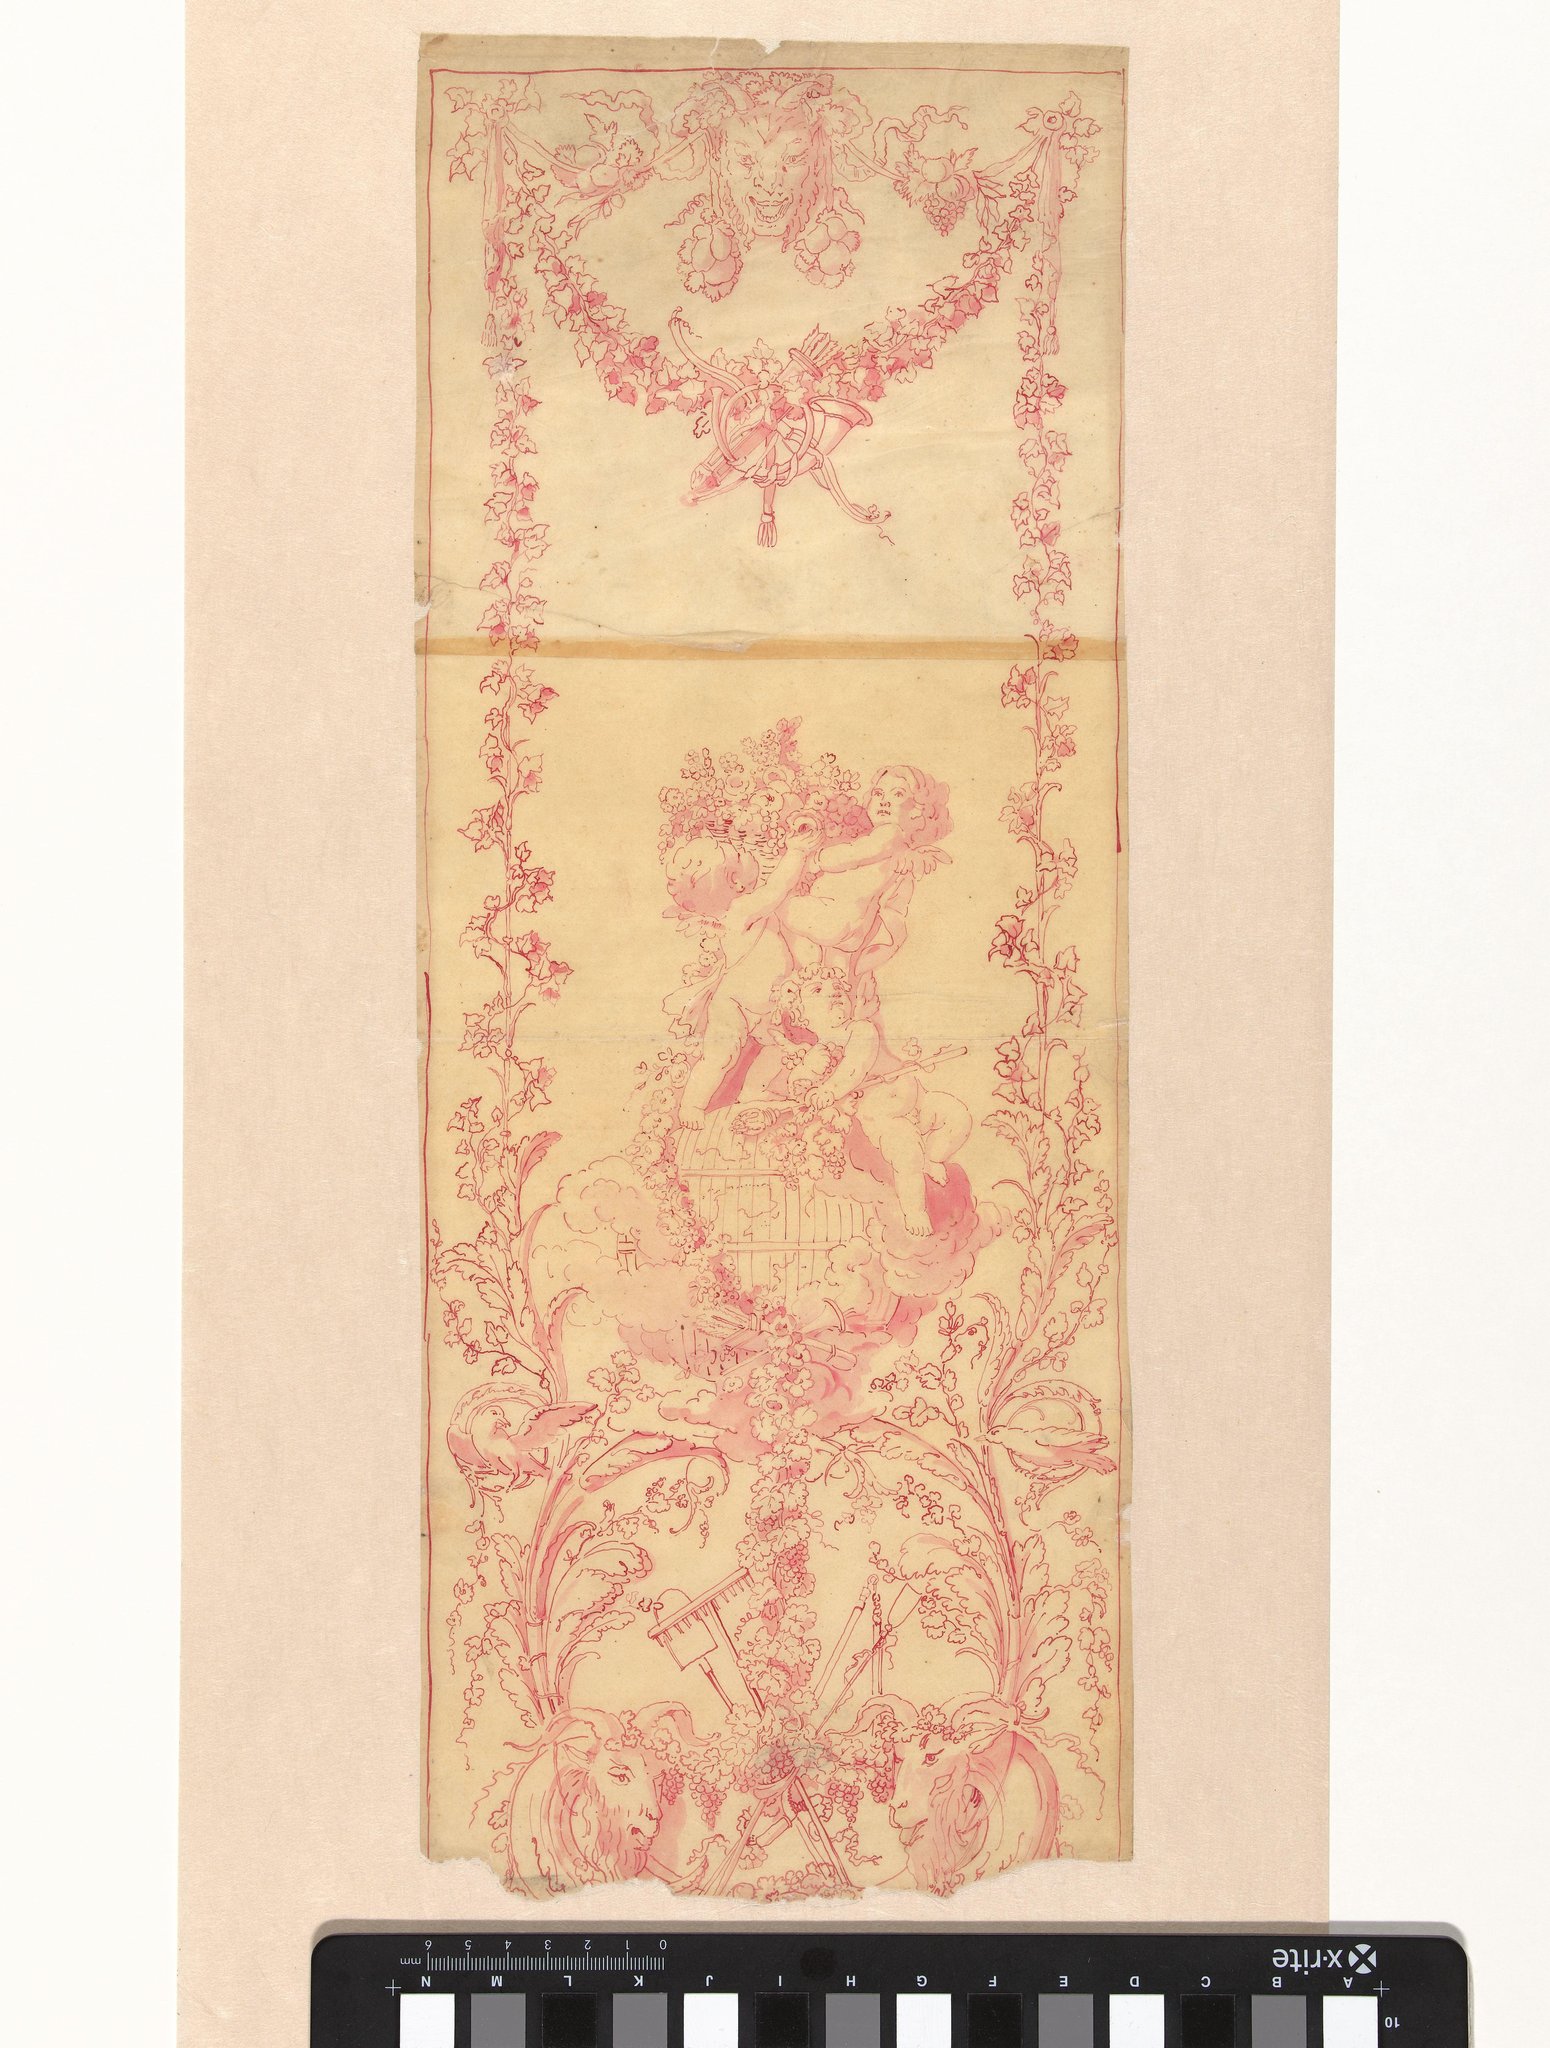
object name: ornamenttekening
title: Putti met druiven in omraming van wingerdranken: de herfst (?)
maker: Anonymous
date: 1800-1900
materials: ink, paper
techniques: brush, pen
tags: autumn, fall, 'autumnus'; 'autunno' (ripa)